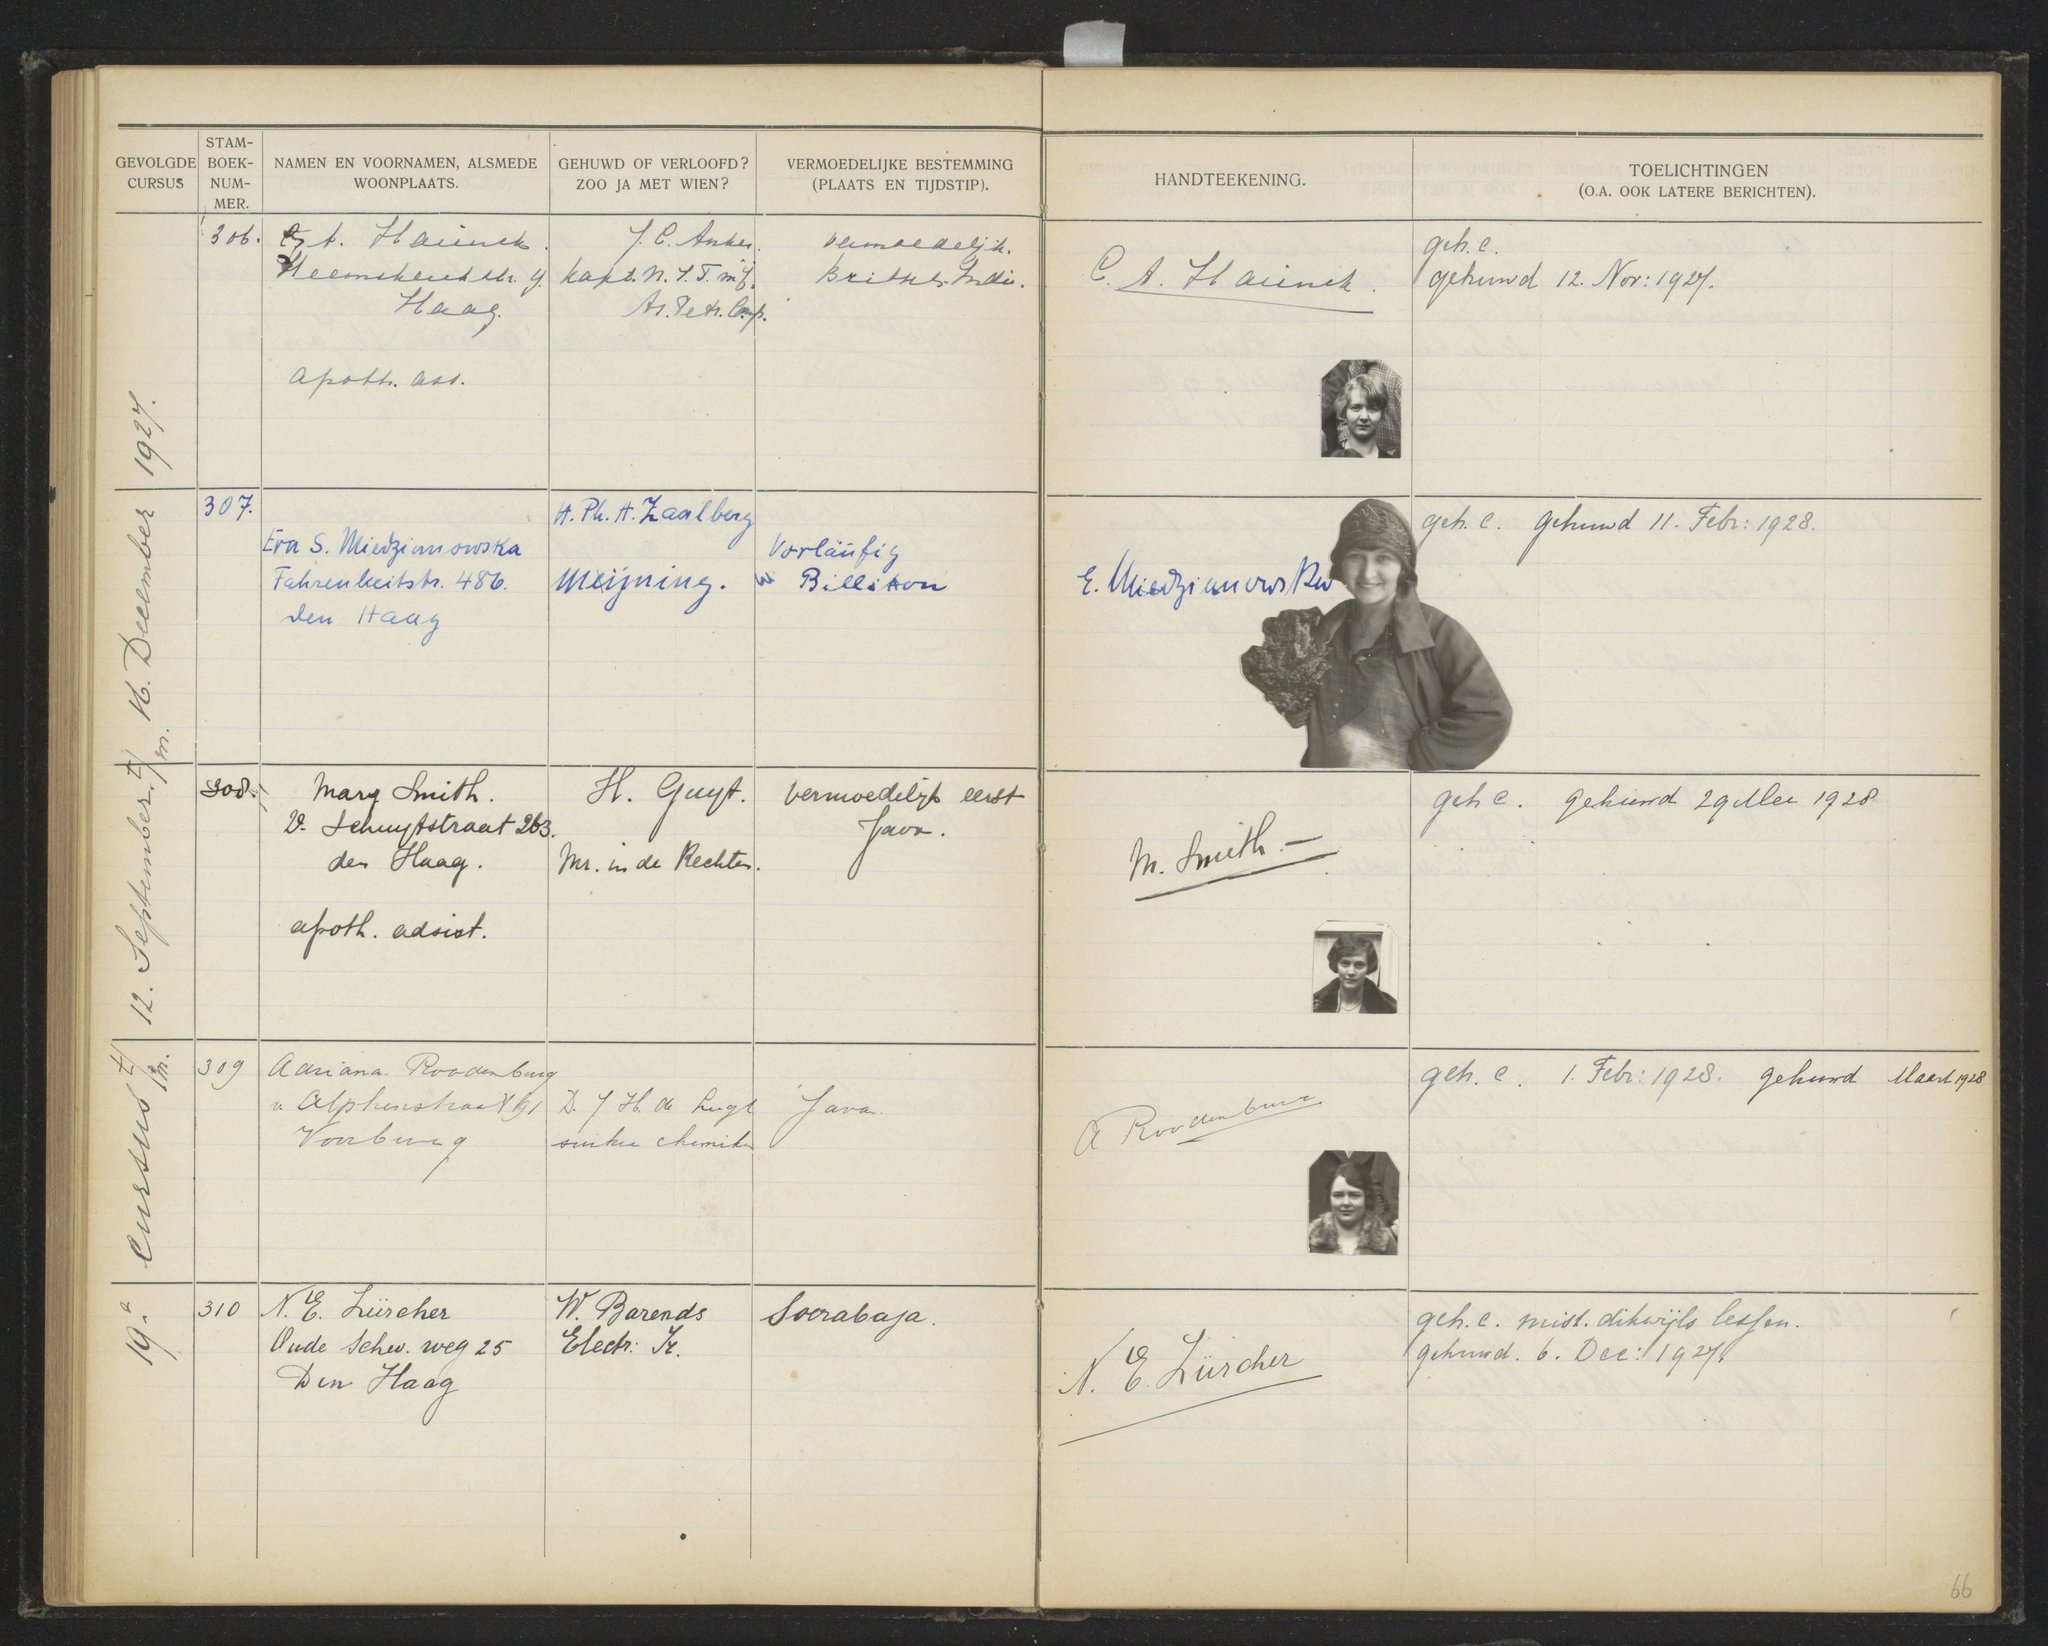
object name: photograph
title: Blad 66 uit Stamboek van de leerlingen der Koloniale School voor Meisjes en Vrouwen te 's-Gravenhage deel I (1921-1929)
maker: Anonymous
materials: paper, photographic support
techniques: photography, printing, writing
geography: the hague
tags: further education (+ pupil), further education, the hague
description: Twee pagina's met gegevens van de deelnemers aan de 19e driemaandelijkse cursus van 12 september tot en met 16 december 1927, stamboeknummers 306 tot en met 310. Onderdeel van Stamboek van de leerlingen der Koloniale School voor Meisjes en Vrouwen te 's-Gravenhage deel I (1921-1929).